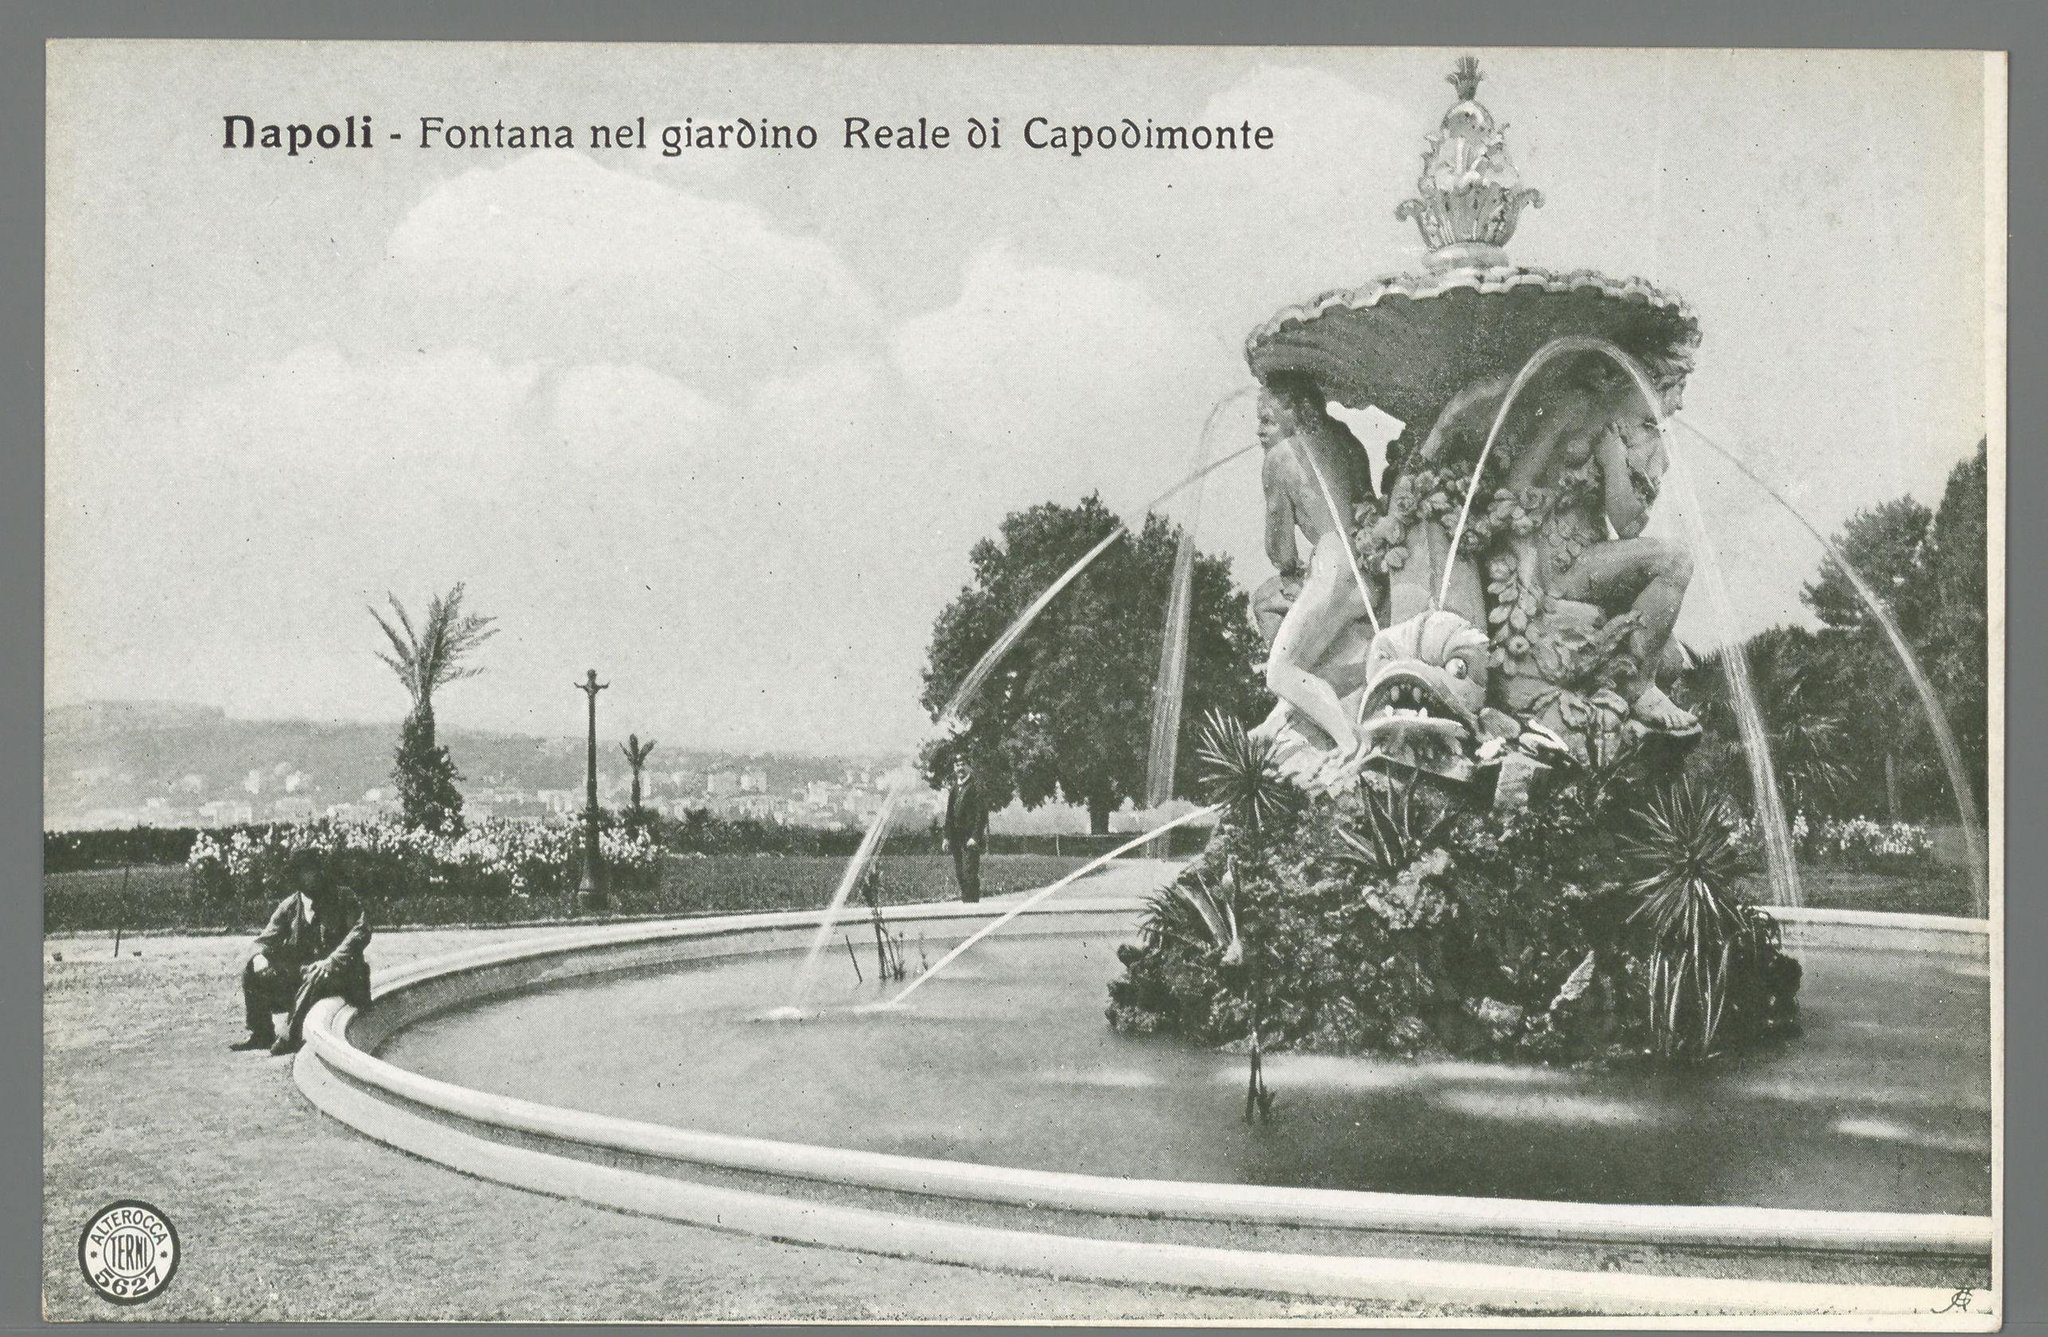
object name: photomechanical print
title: Napoli. Fontana nel Giardino Reale di Capodimonte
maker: Anonymous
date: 1906-1910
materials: cardboard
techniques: autotype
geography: terni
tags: public gardens, park (+ city(-scape) with figures, staffage), garden fountain